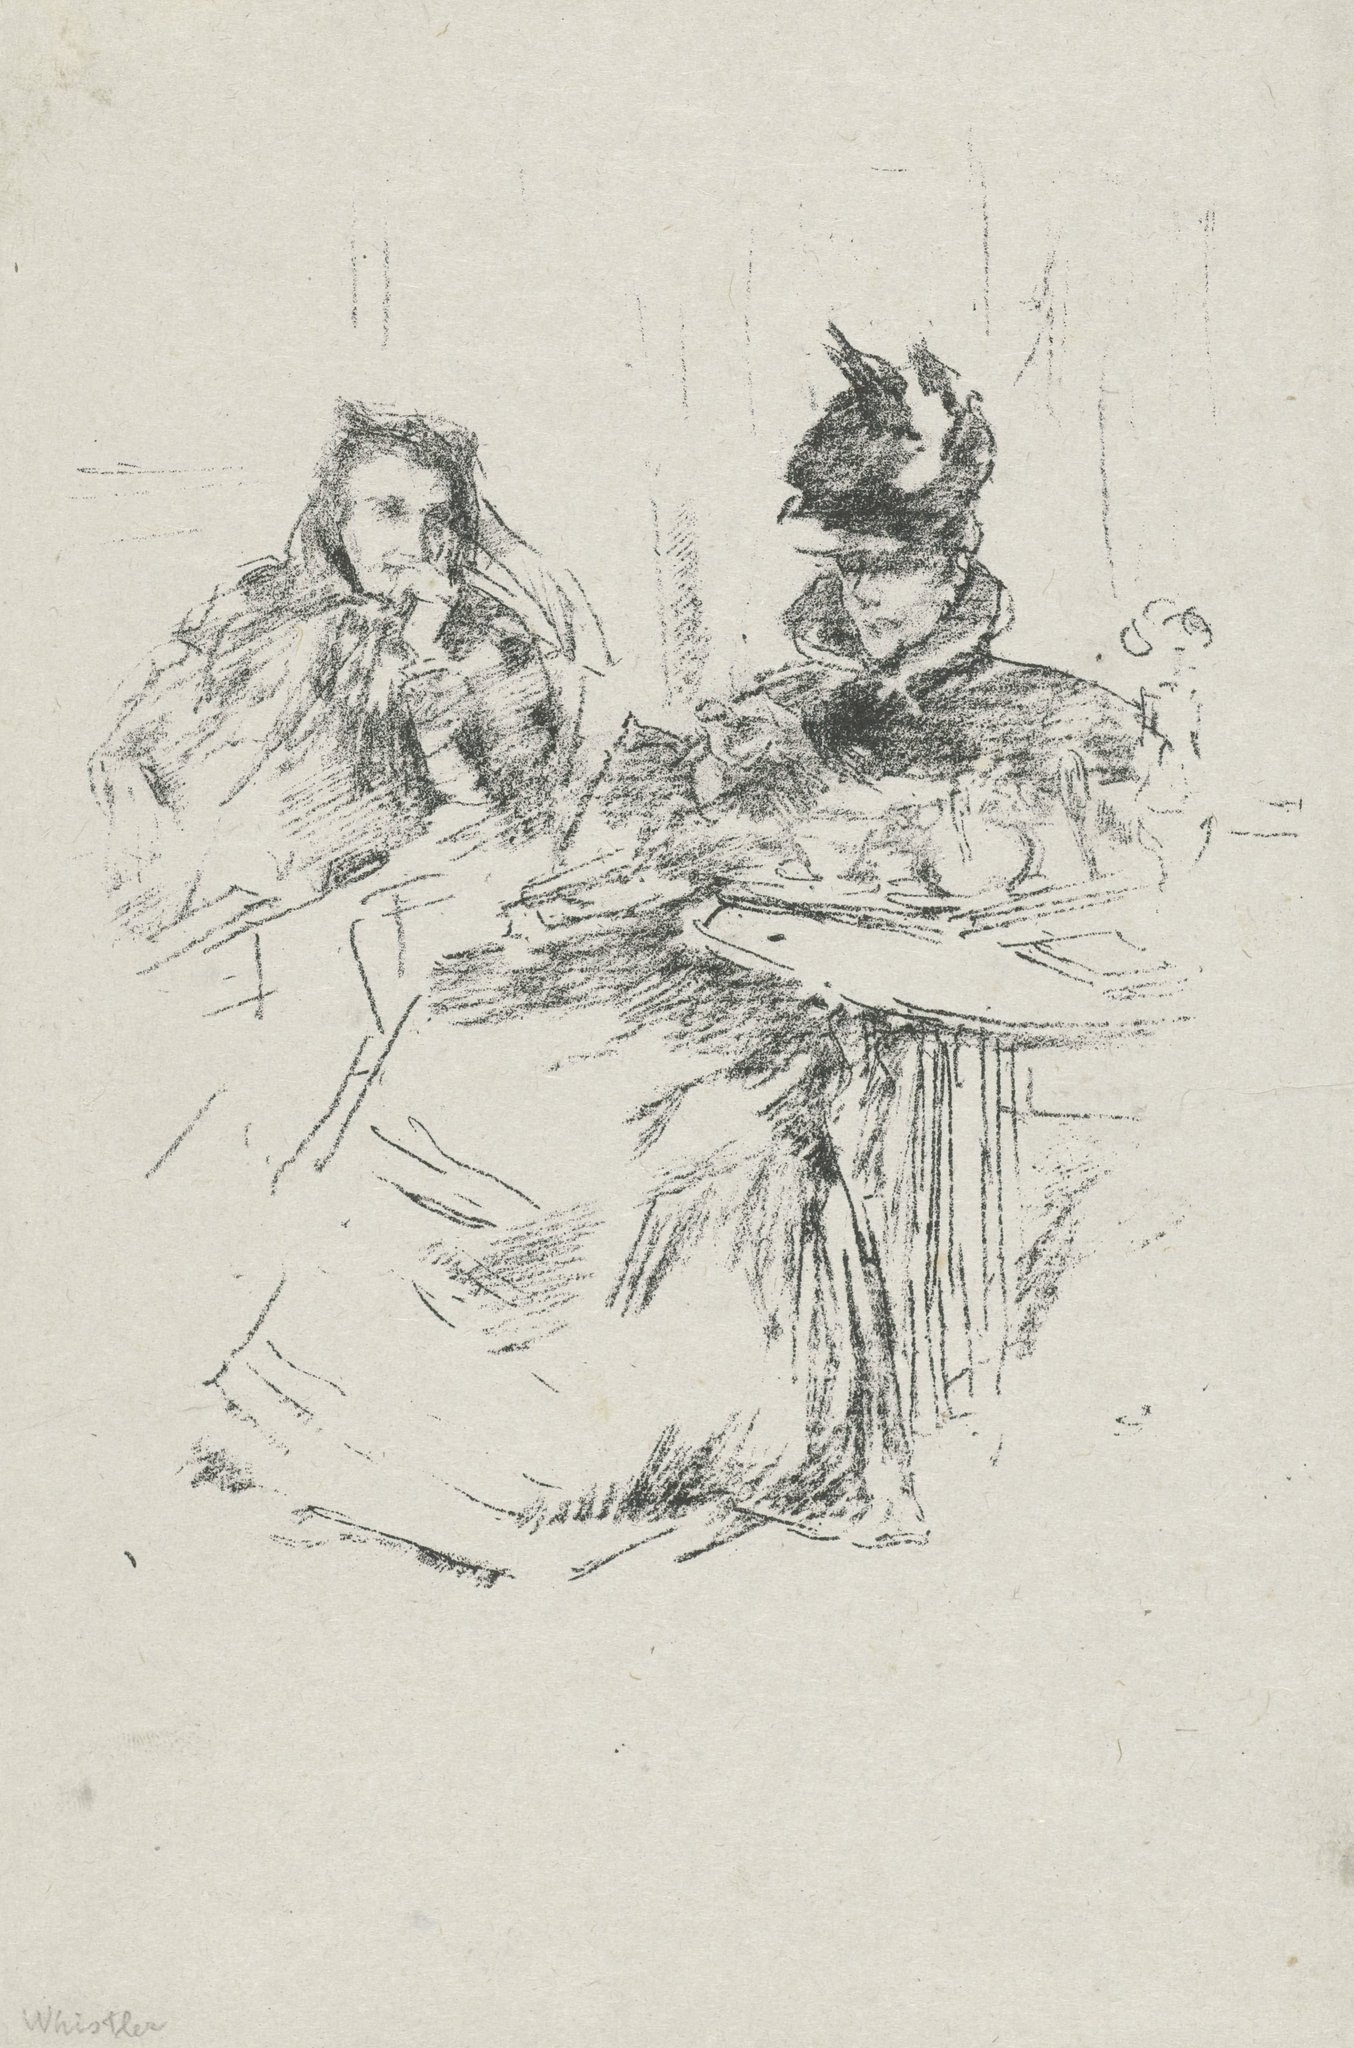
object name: print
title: The afternoon tea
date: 1893-1897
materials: paper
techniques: lithograph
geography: paris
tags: high tea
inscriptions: collector's mark: Lugt 2228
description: Twee vrouwen drinken thee op een terras.